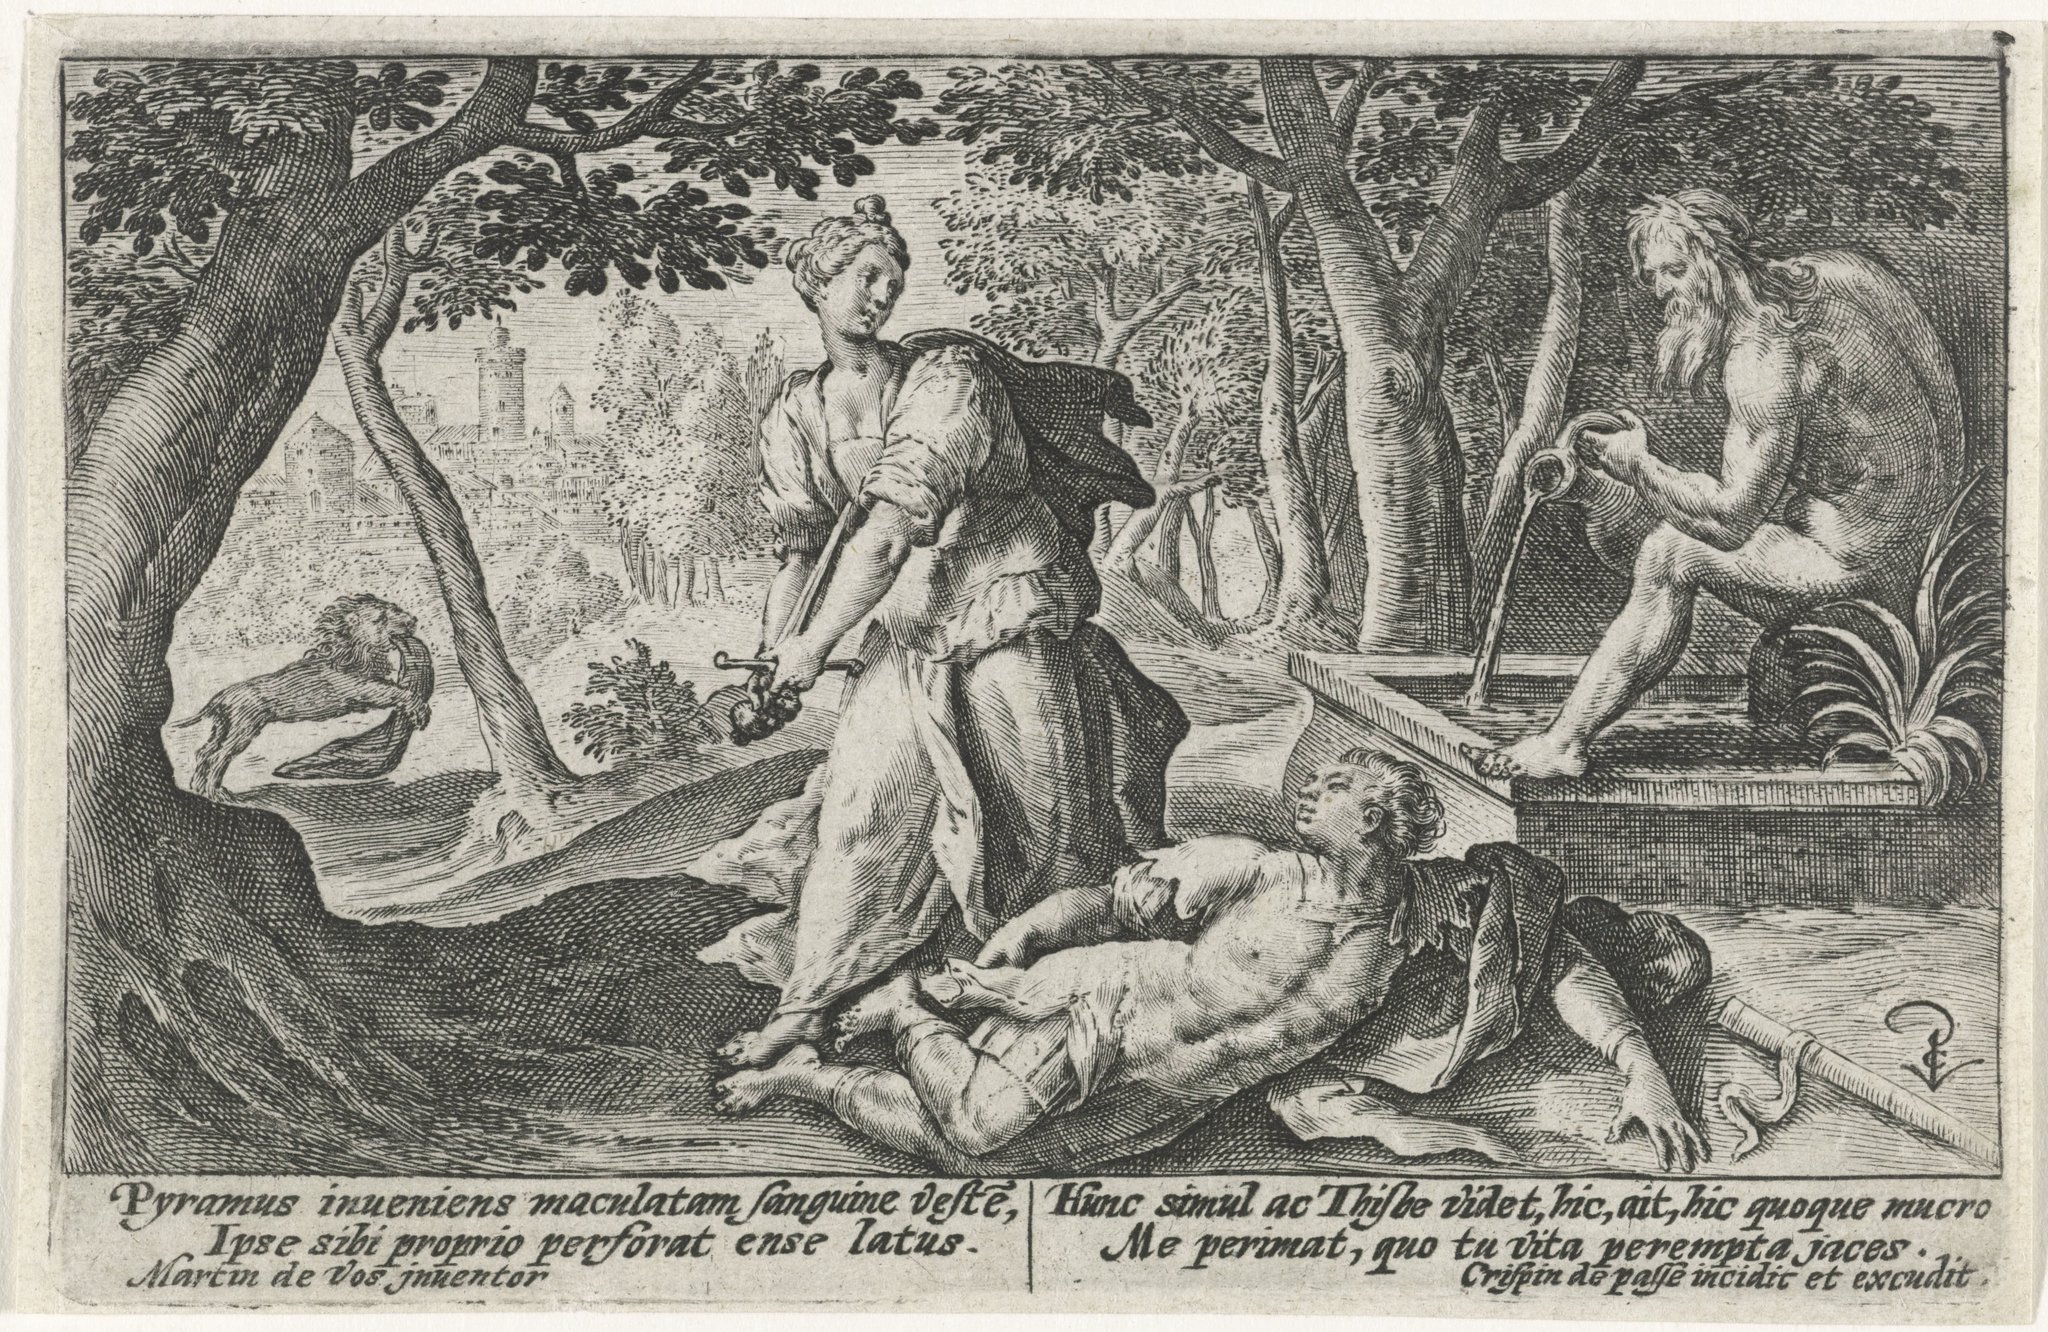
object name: print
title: Pyramus en Thisbe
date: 1602-1607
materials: paper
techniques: engraving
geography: cologne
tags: thisbe kills herself with pyramus' sword (the scene may be represented near a fountain), thisbe discovers the dying pyramus (the scene may be represented near a fountain)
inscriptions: collector's mark: Lugt 2228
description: Pyramus stak zichzelf neer met zijn zwaard nadat hij meende dat Thisbe door een leeuw was gedood. Thisbe ontdekt haar stervende geliefde, waarop zij zichzelf ook neersteekt. Op de achtergrond de leeuw met de sluier van Thisbe. In de marge een vierregelig onderschrift, in twee kolommen, in het Latijn.